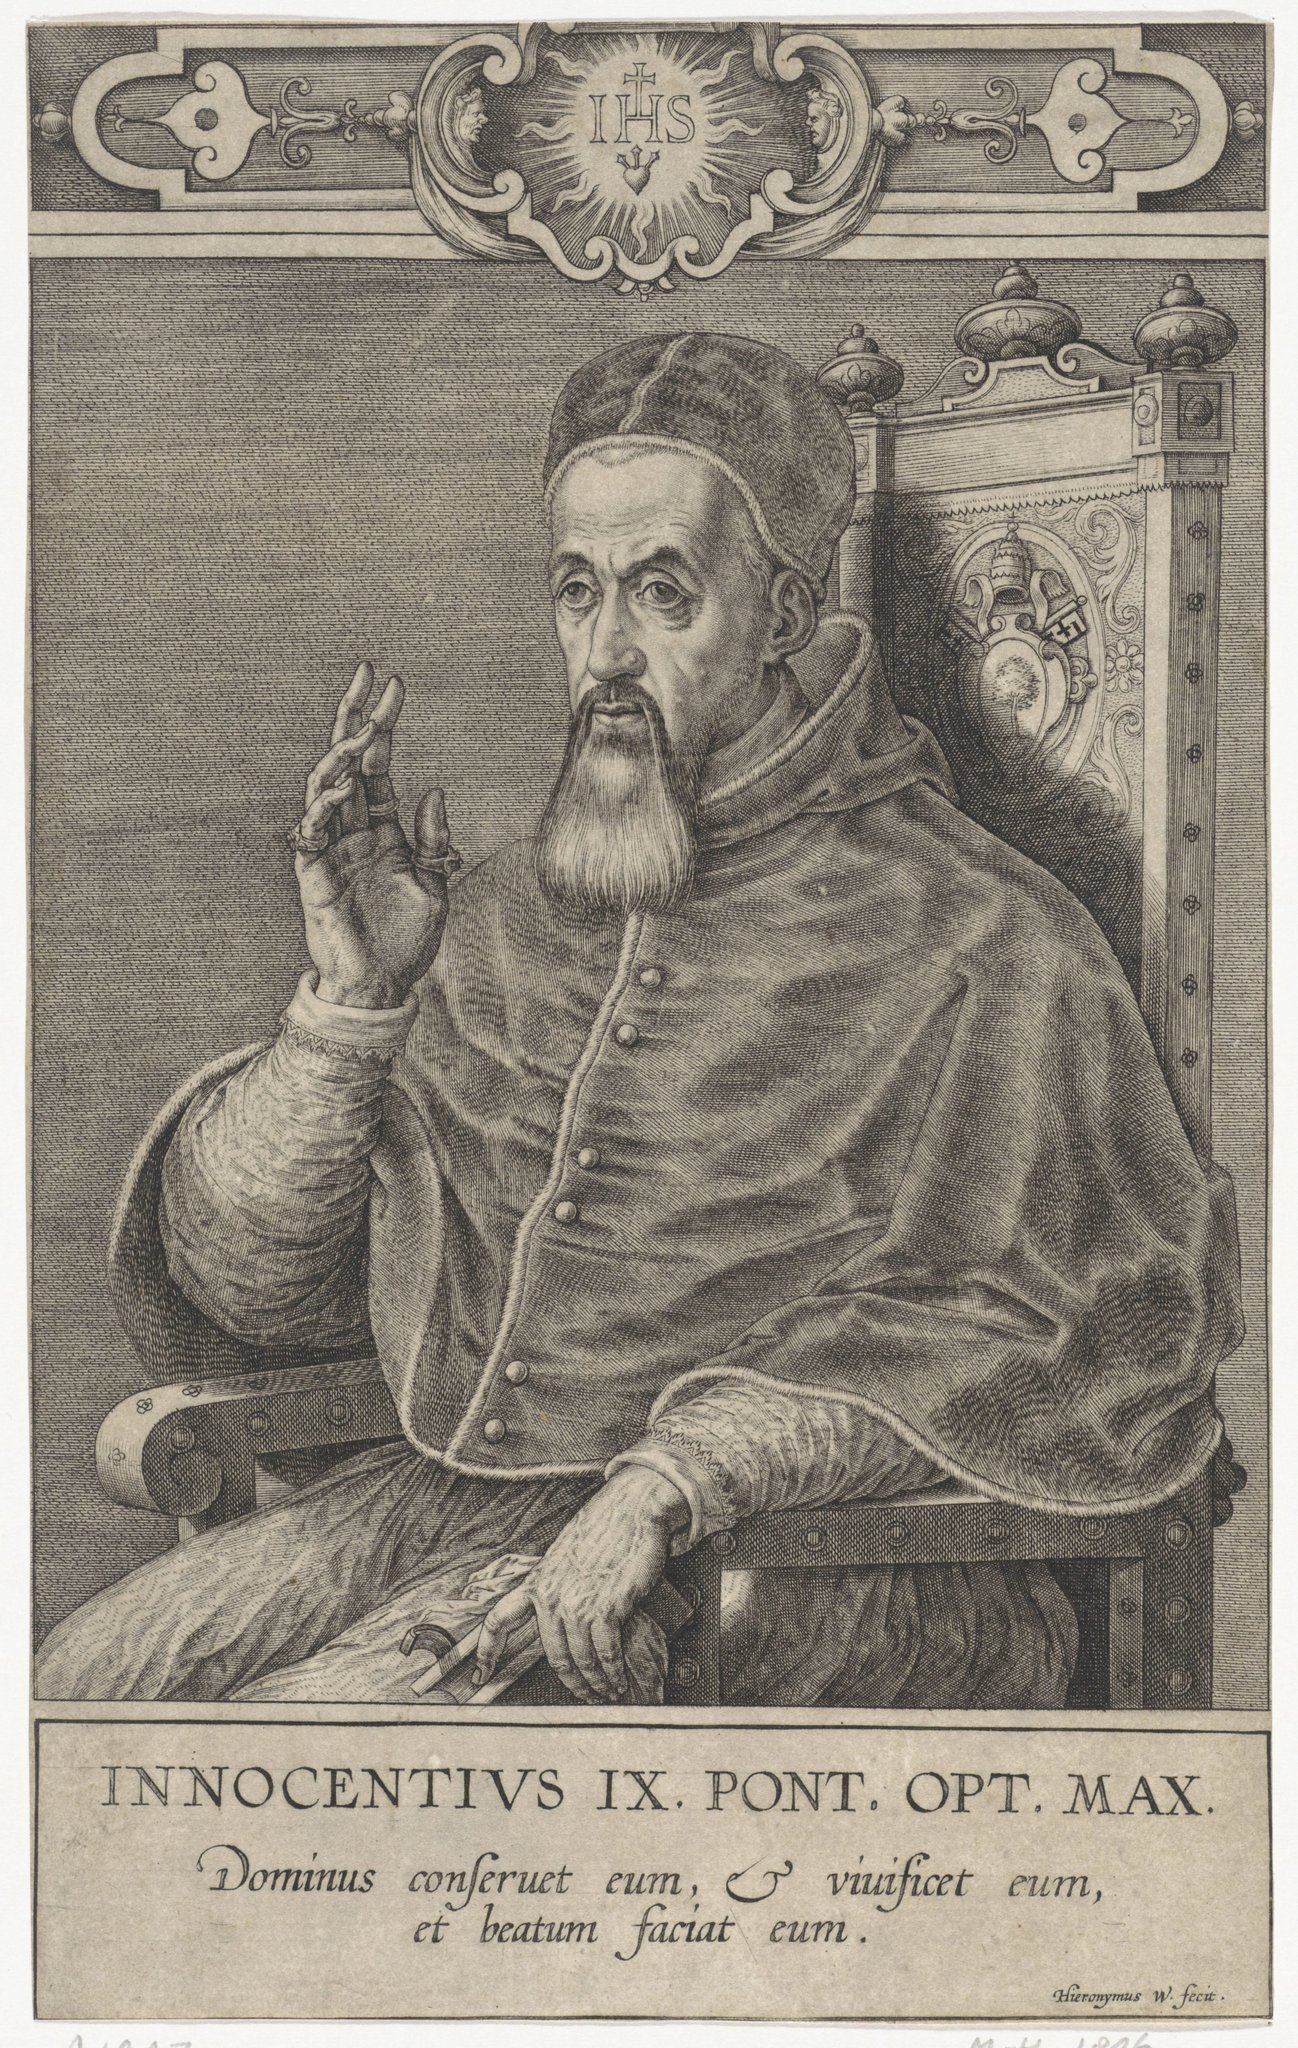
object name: print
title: Portret van paus Innocentius IX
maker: hieronymus wierix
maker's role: draughtsman, print maker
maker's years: 1553-1619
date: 1589-1593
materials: paper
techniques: engraving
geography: antwerp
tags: ihs ('iesus hominum salvator') ~ symbol of christ, pope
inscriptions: collector's mark: Lugt 2228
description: Hij zit op zijn zetel en maakt een zegenend gebaar. Bovenaan in een cartouche het embleem van de jezuïeten. In de marge de naam van de geportretteerde en een tweeregelig onderschrift in het Latijn.